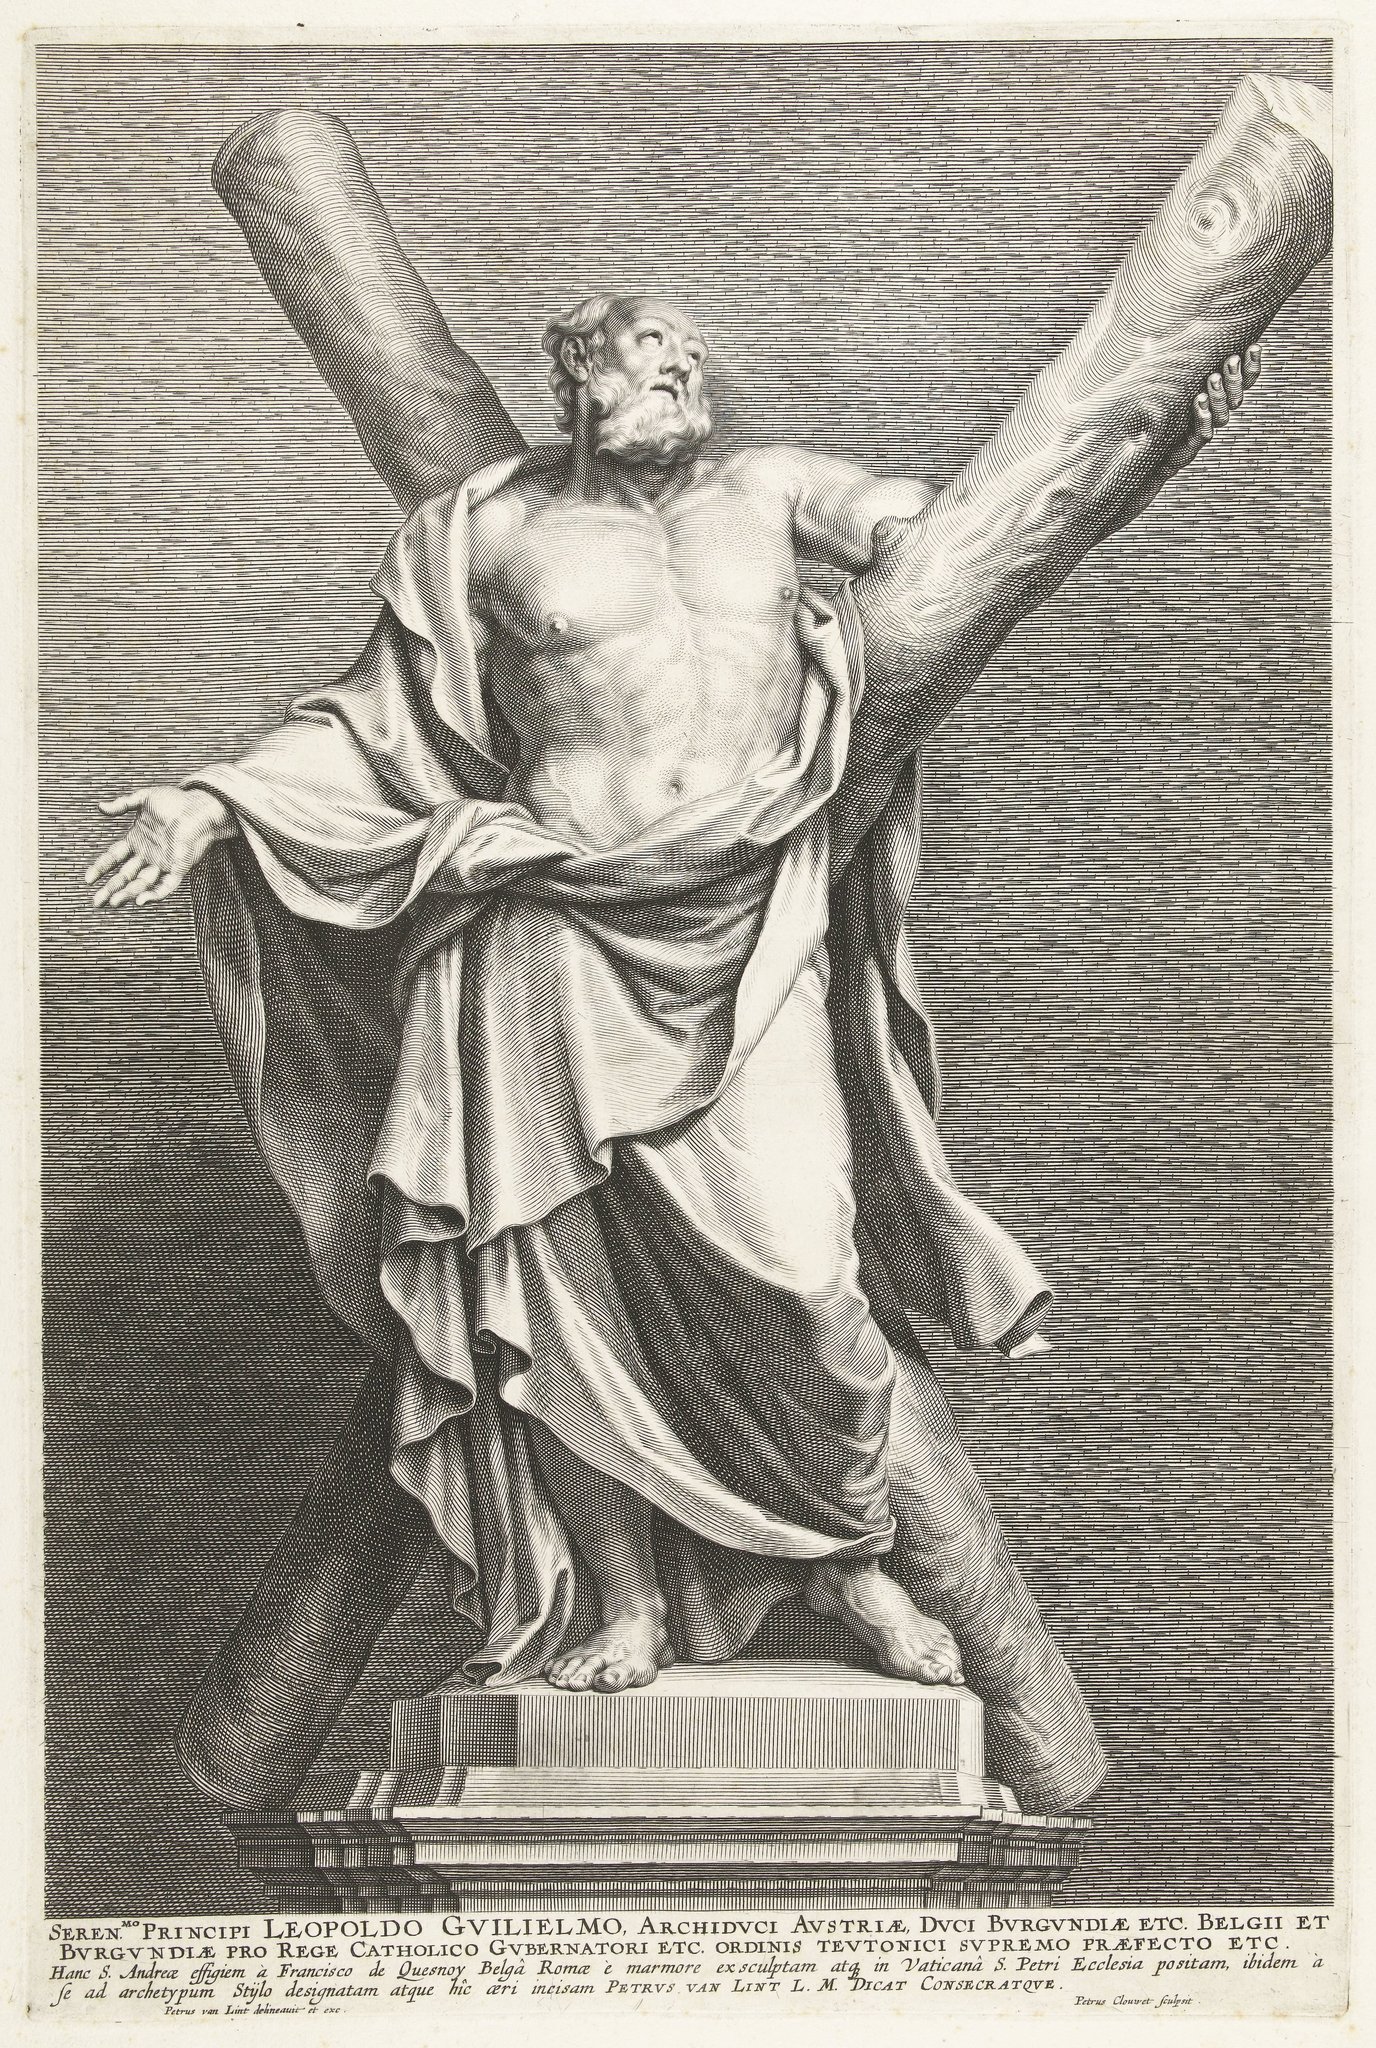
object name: print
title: Standbeeld van de Heilige Andreas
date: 1639-1670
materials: paper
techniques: engraving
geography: antwerp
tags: the apostle andrew; possible attributes: book, x-shaped cross, fish, fishing-net, rope, scroll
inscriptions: collector's mark: Lugt 240, collector's mark: Lugt 2228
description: De prent toont een standbeeld van de Heilige Andreas, met x-vormig kruis. Het standbeeld is van François Duquesnoy en staat in het Vaticaan. De prent heeft een Latijns onderschrift.